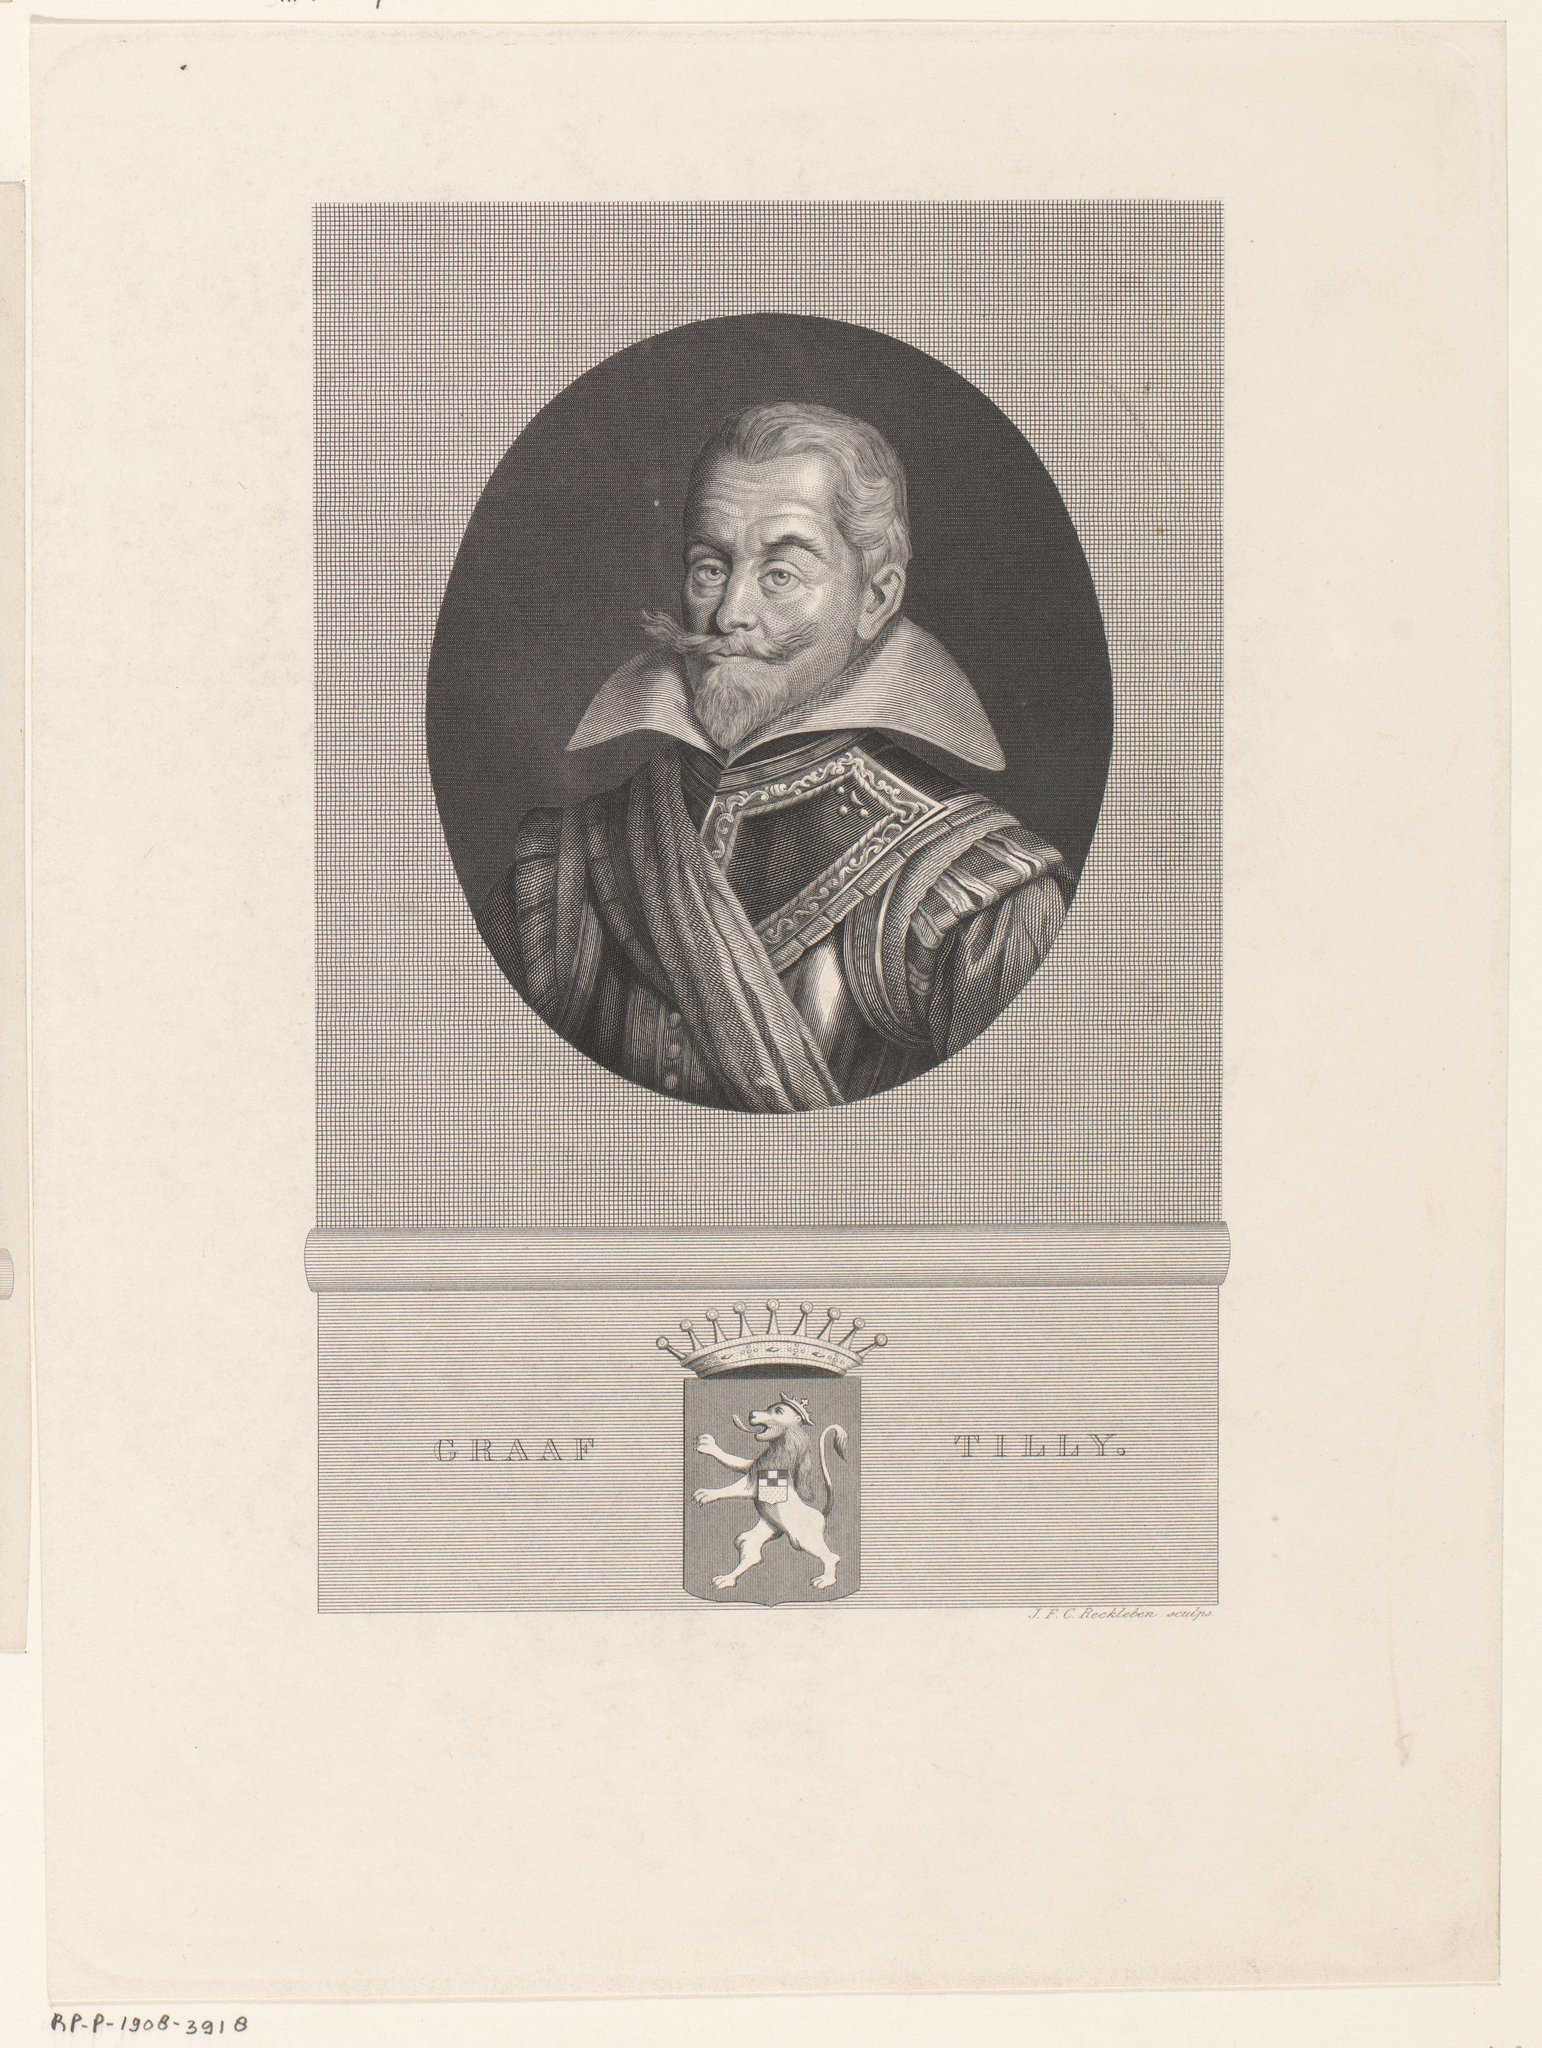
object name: print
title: Portret van Johan 't Serclaes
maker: jan frederik christiaan reckleben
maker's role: print maker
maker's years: 1819-1879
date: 1861-1863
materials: paper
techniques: engraving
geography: amsterdam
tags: huurling generaal, johan t' serclaes (graaf van tilly)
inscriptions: collector's mark: Lugt 2228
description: Illustratie in: Arend, Johannes Pieter. Algemeene geschiedenis des vaderlands van de vroegste tijden tot op heden. 5 delen, Amsterdam: Schleijer, J.F. 1840-1884, dl. 3.4, p. 631.